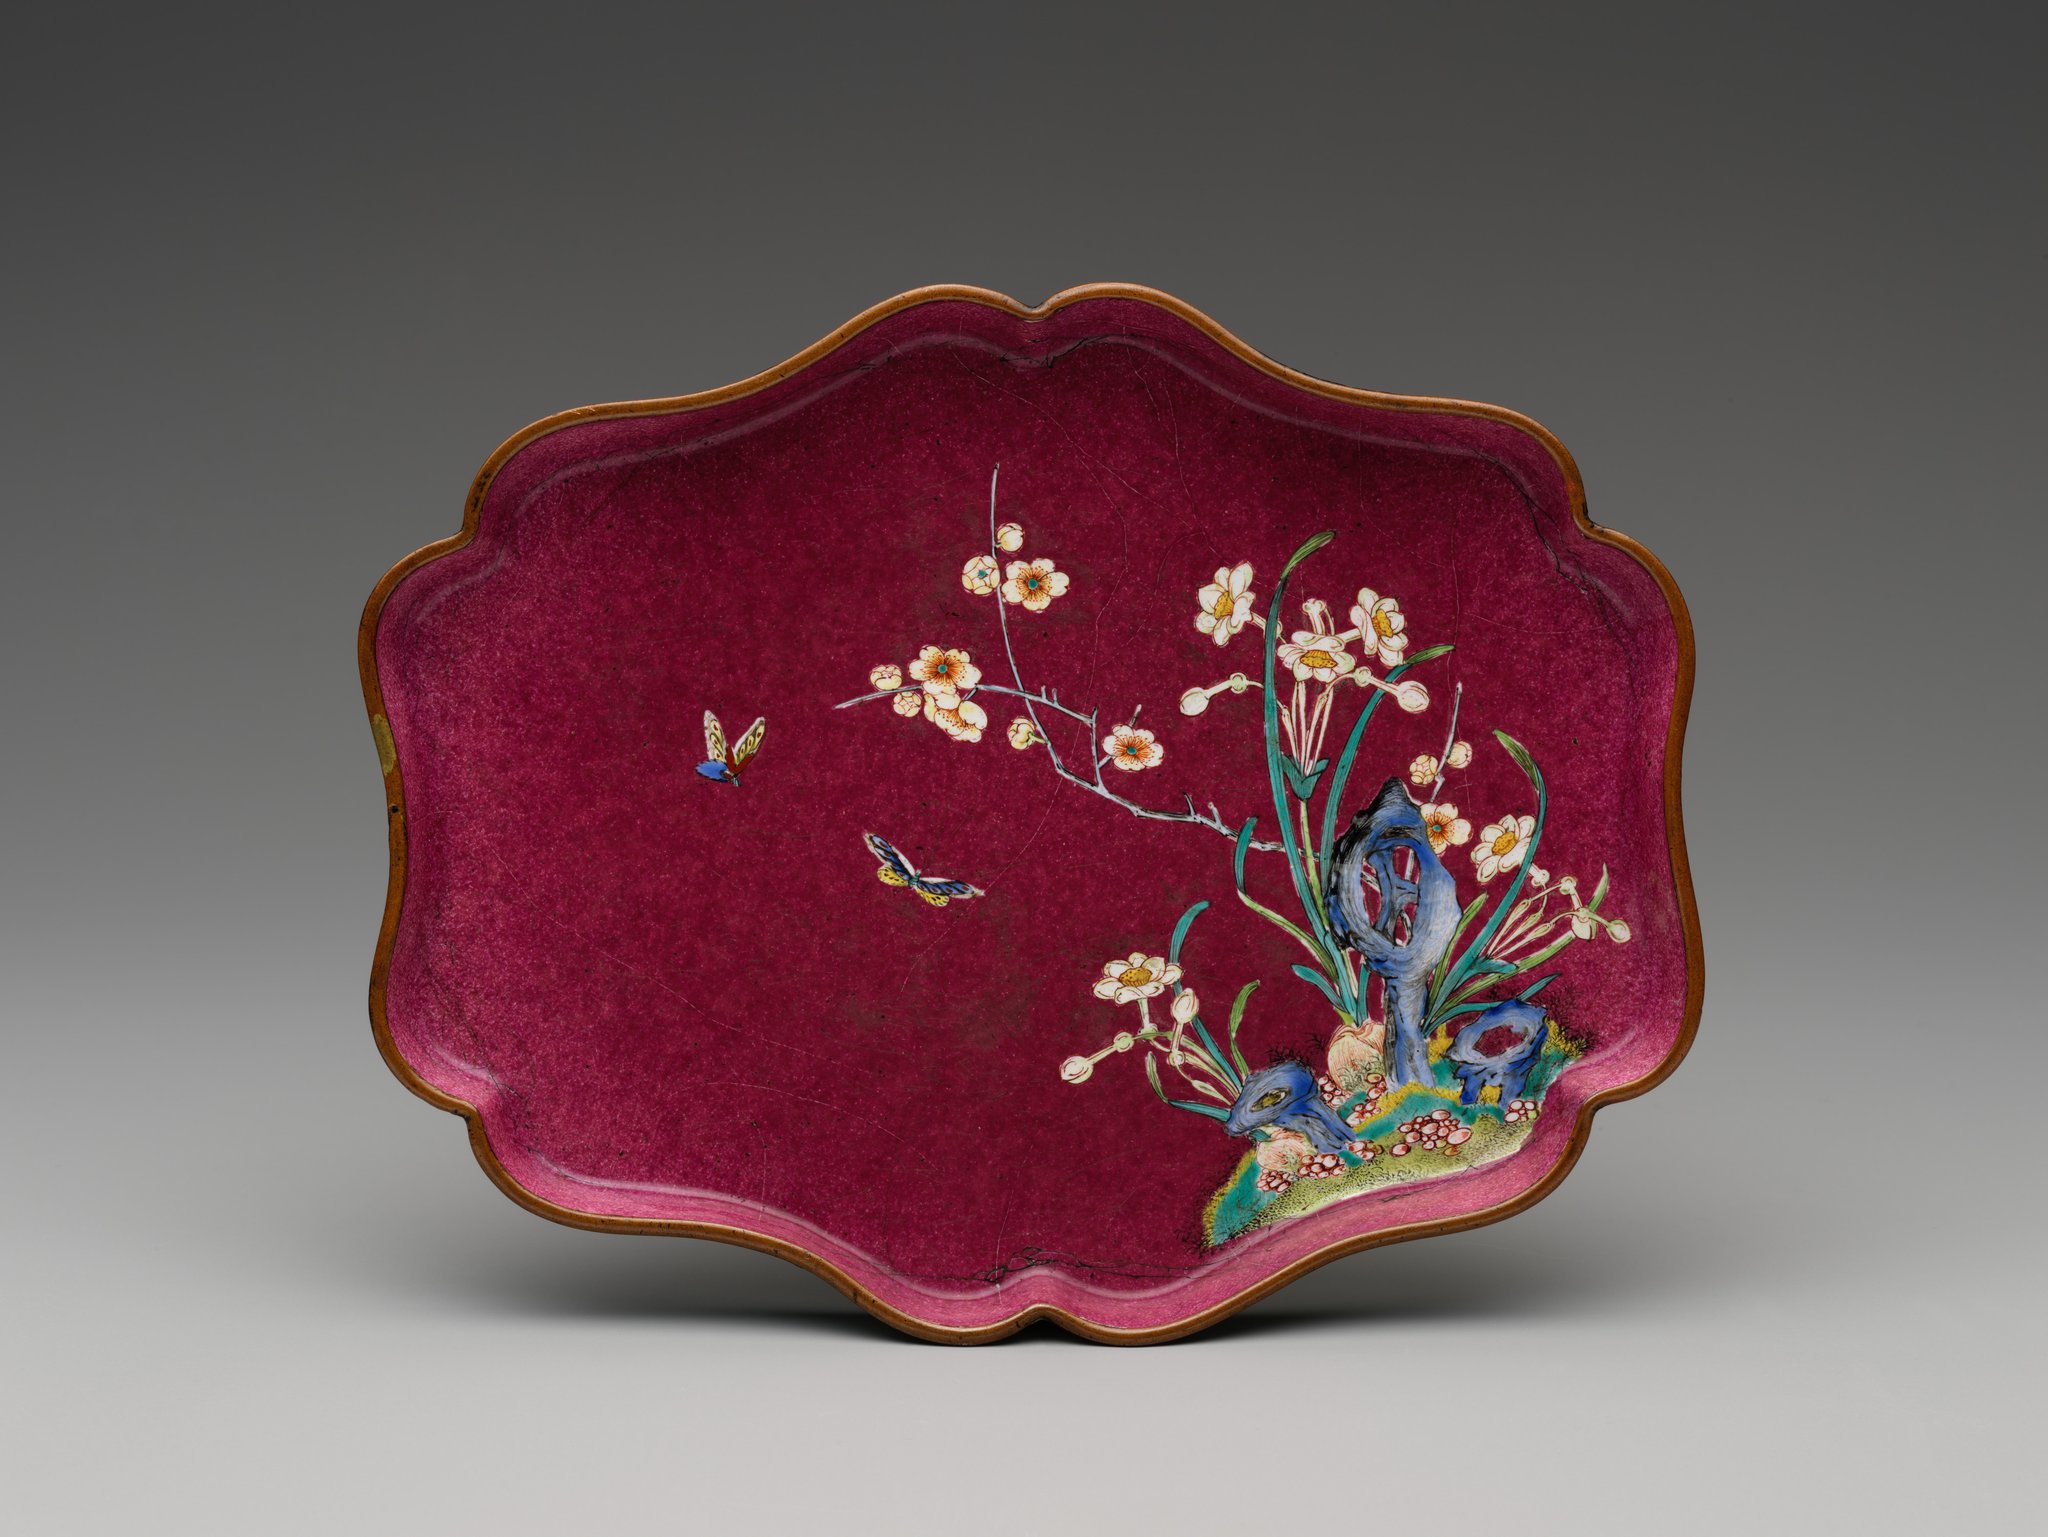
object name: tray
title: Lobed tray with rock, flowers, and butterflies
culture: chinese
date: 1801-1900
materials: copper alloy, enamel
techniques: painting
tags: butterflies,plants